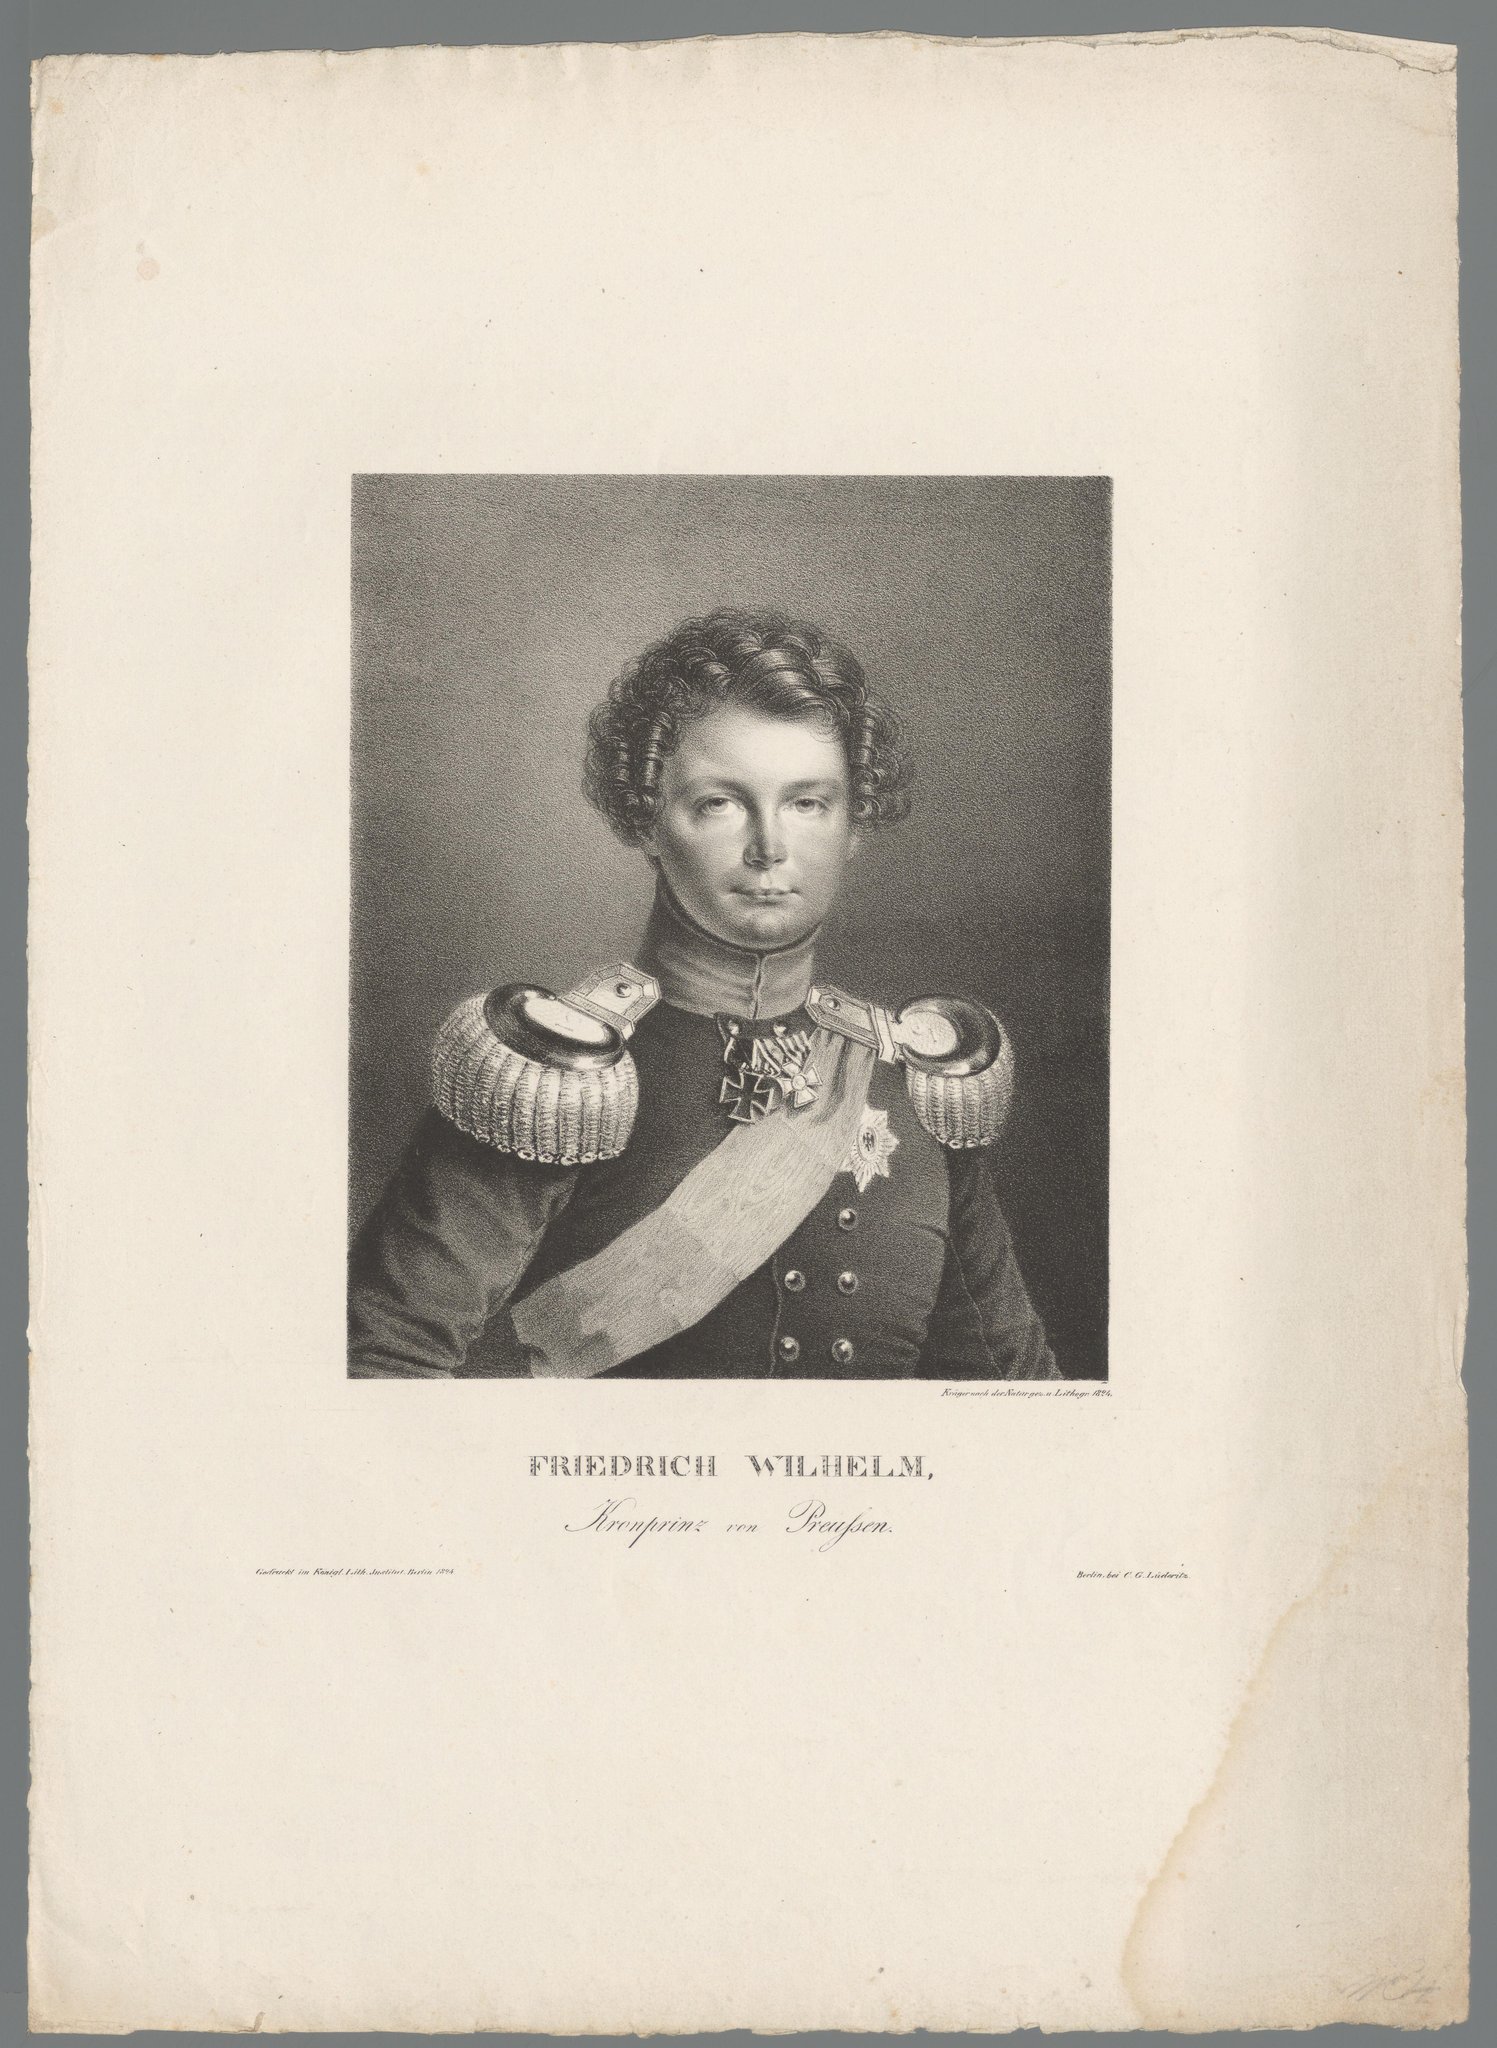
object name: print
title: Friedrich Wilhelm IV van Pruisen, als prins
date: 1824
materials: paper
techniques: lithograph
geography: berlin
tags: frederik willem iv (koning van pruisen), historical persons, crown prince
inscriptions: collector's mark: Lugt 2228